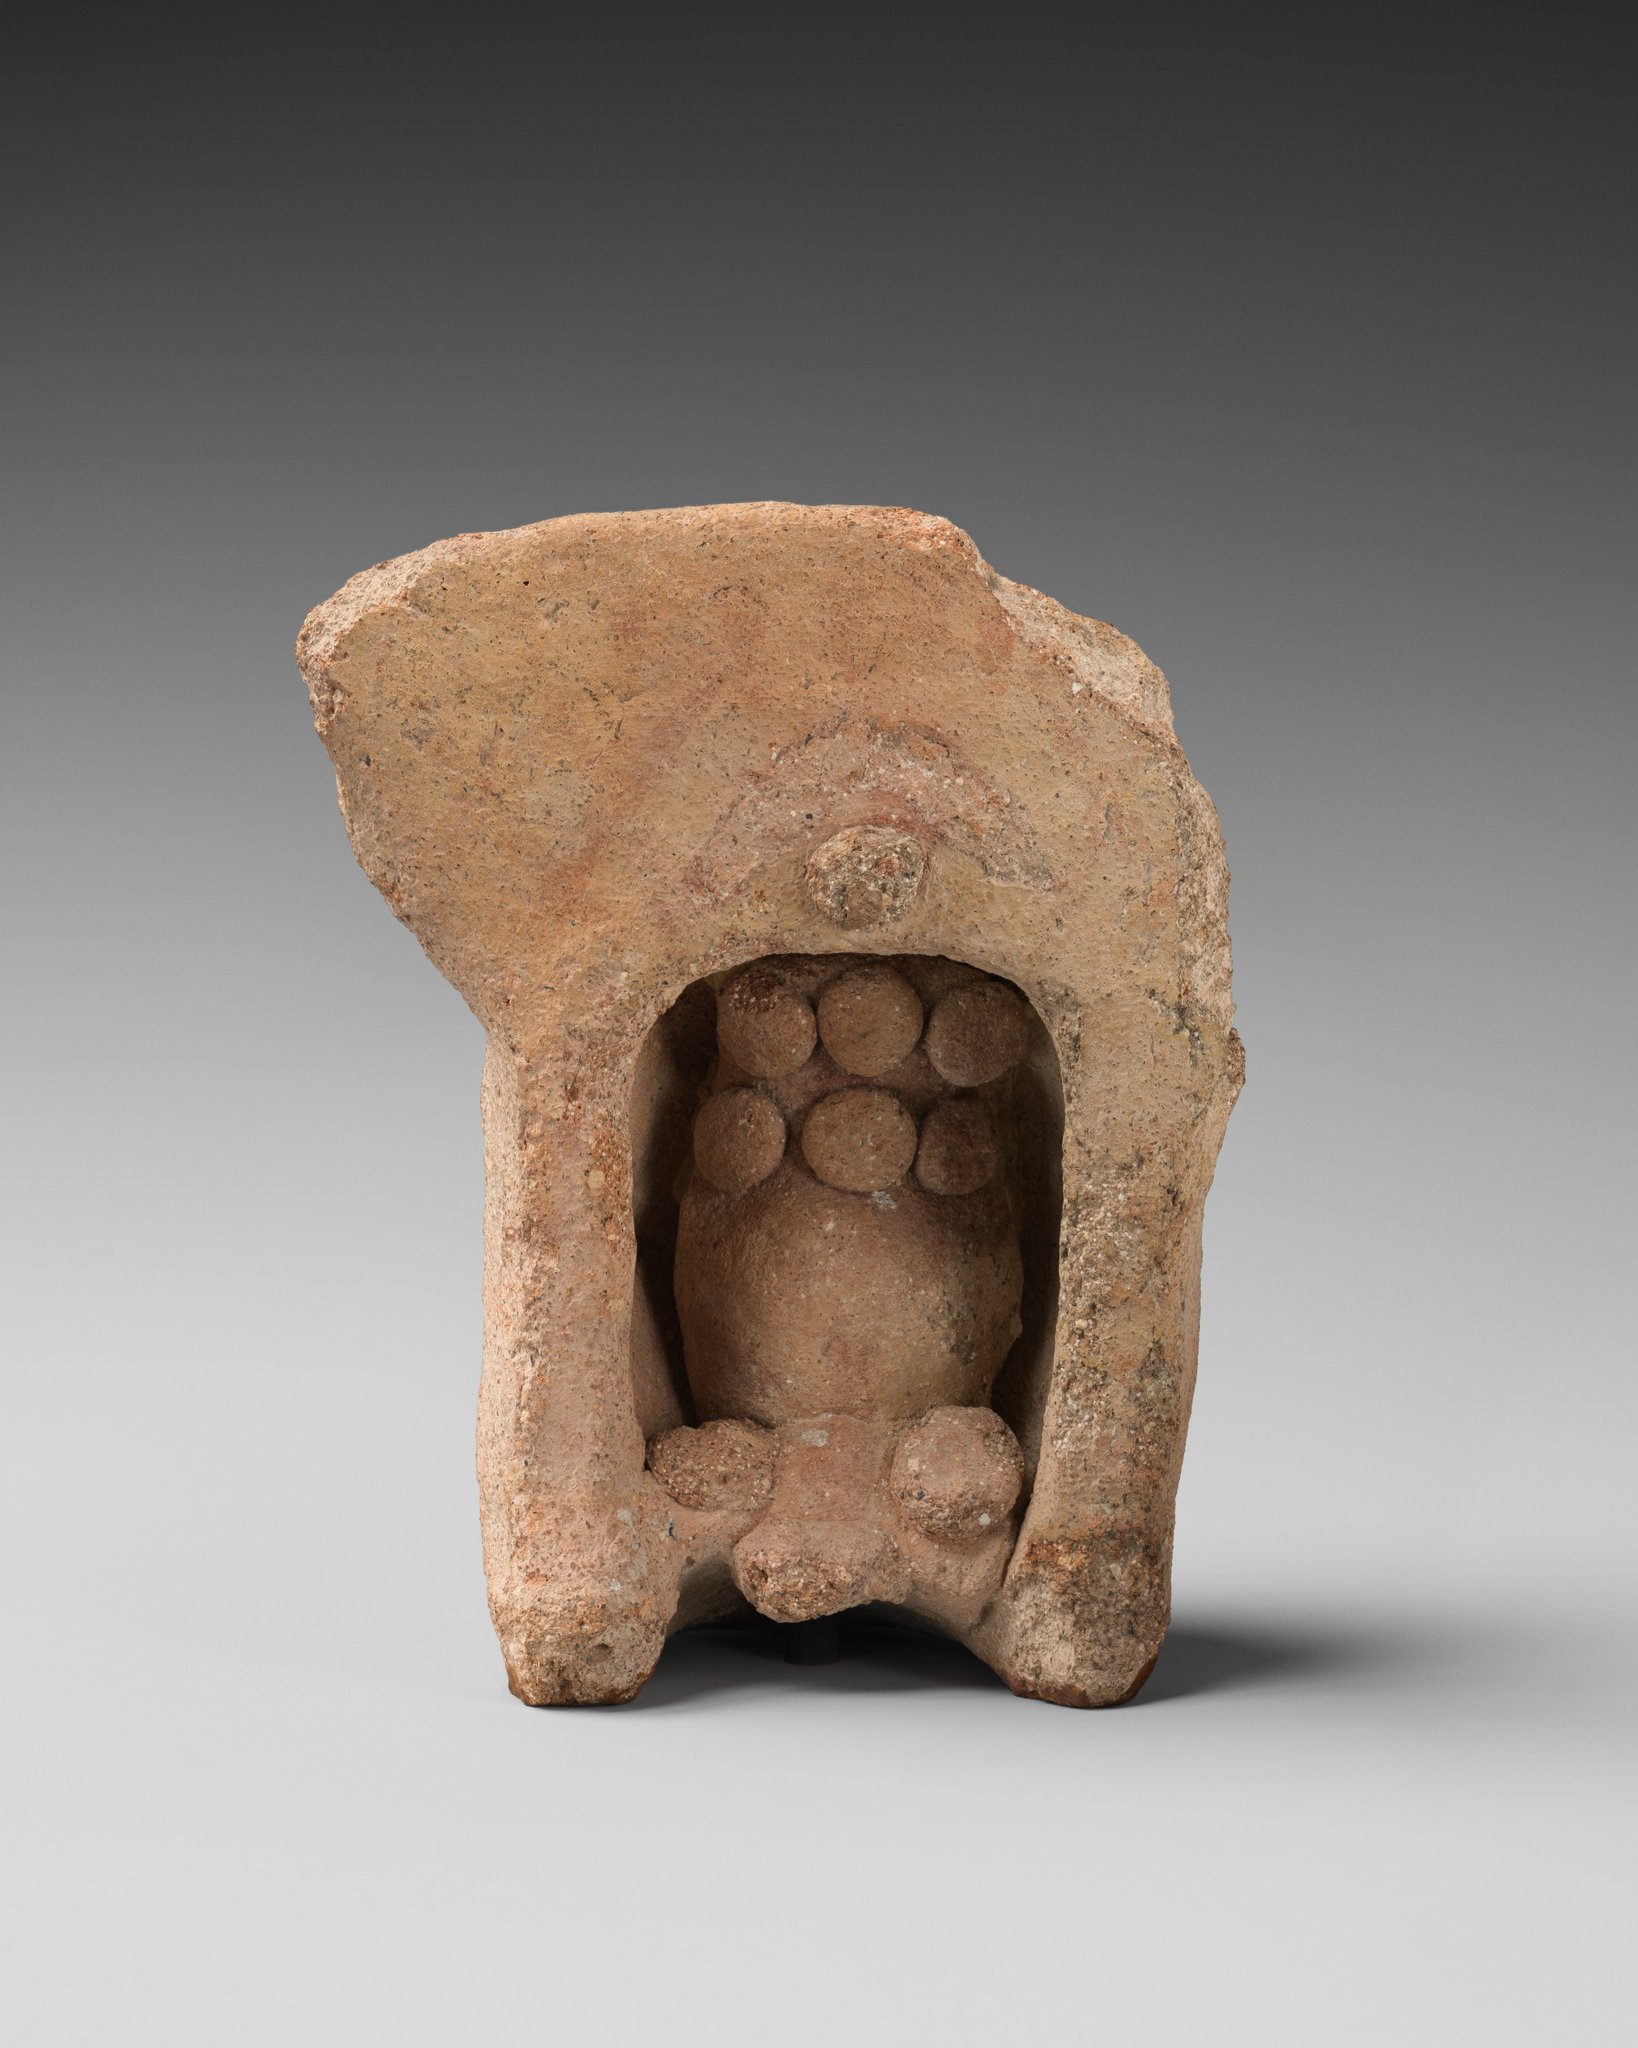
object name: altar shrine naiskos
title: Terracotta model of a shrine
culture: cypriot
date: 600-480 BCE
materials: terracotta